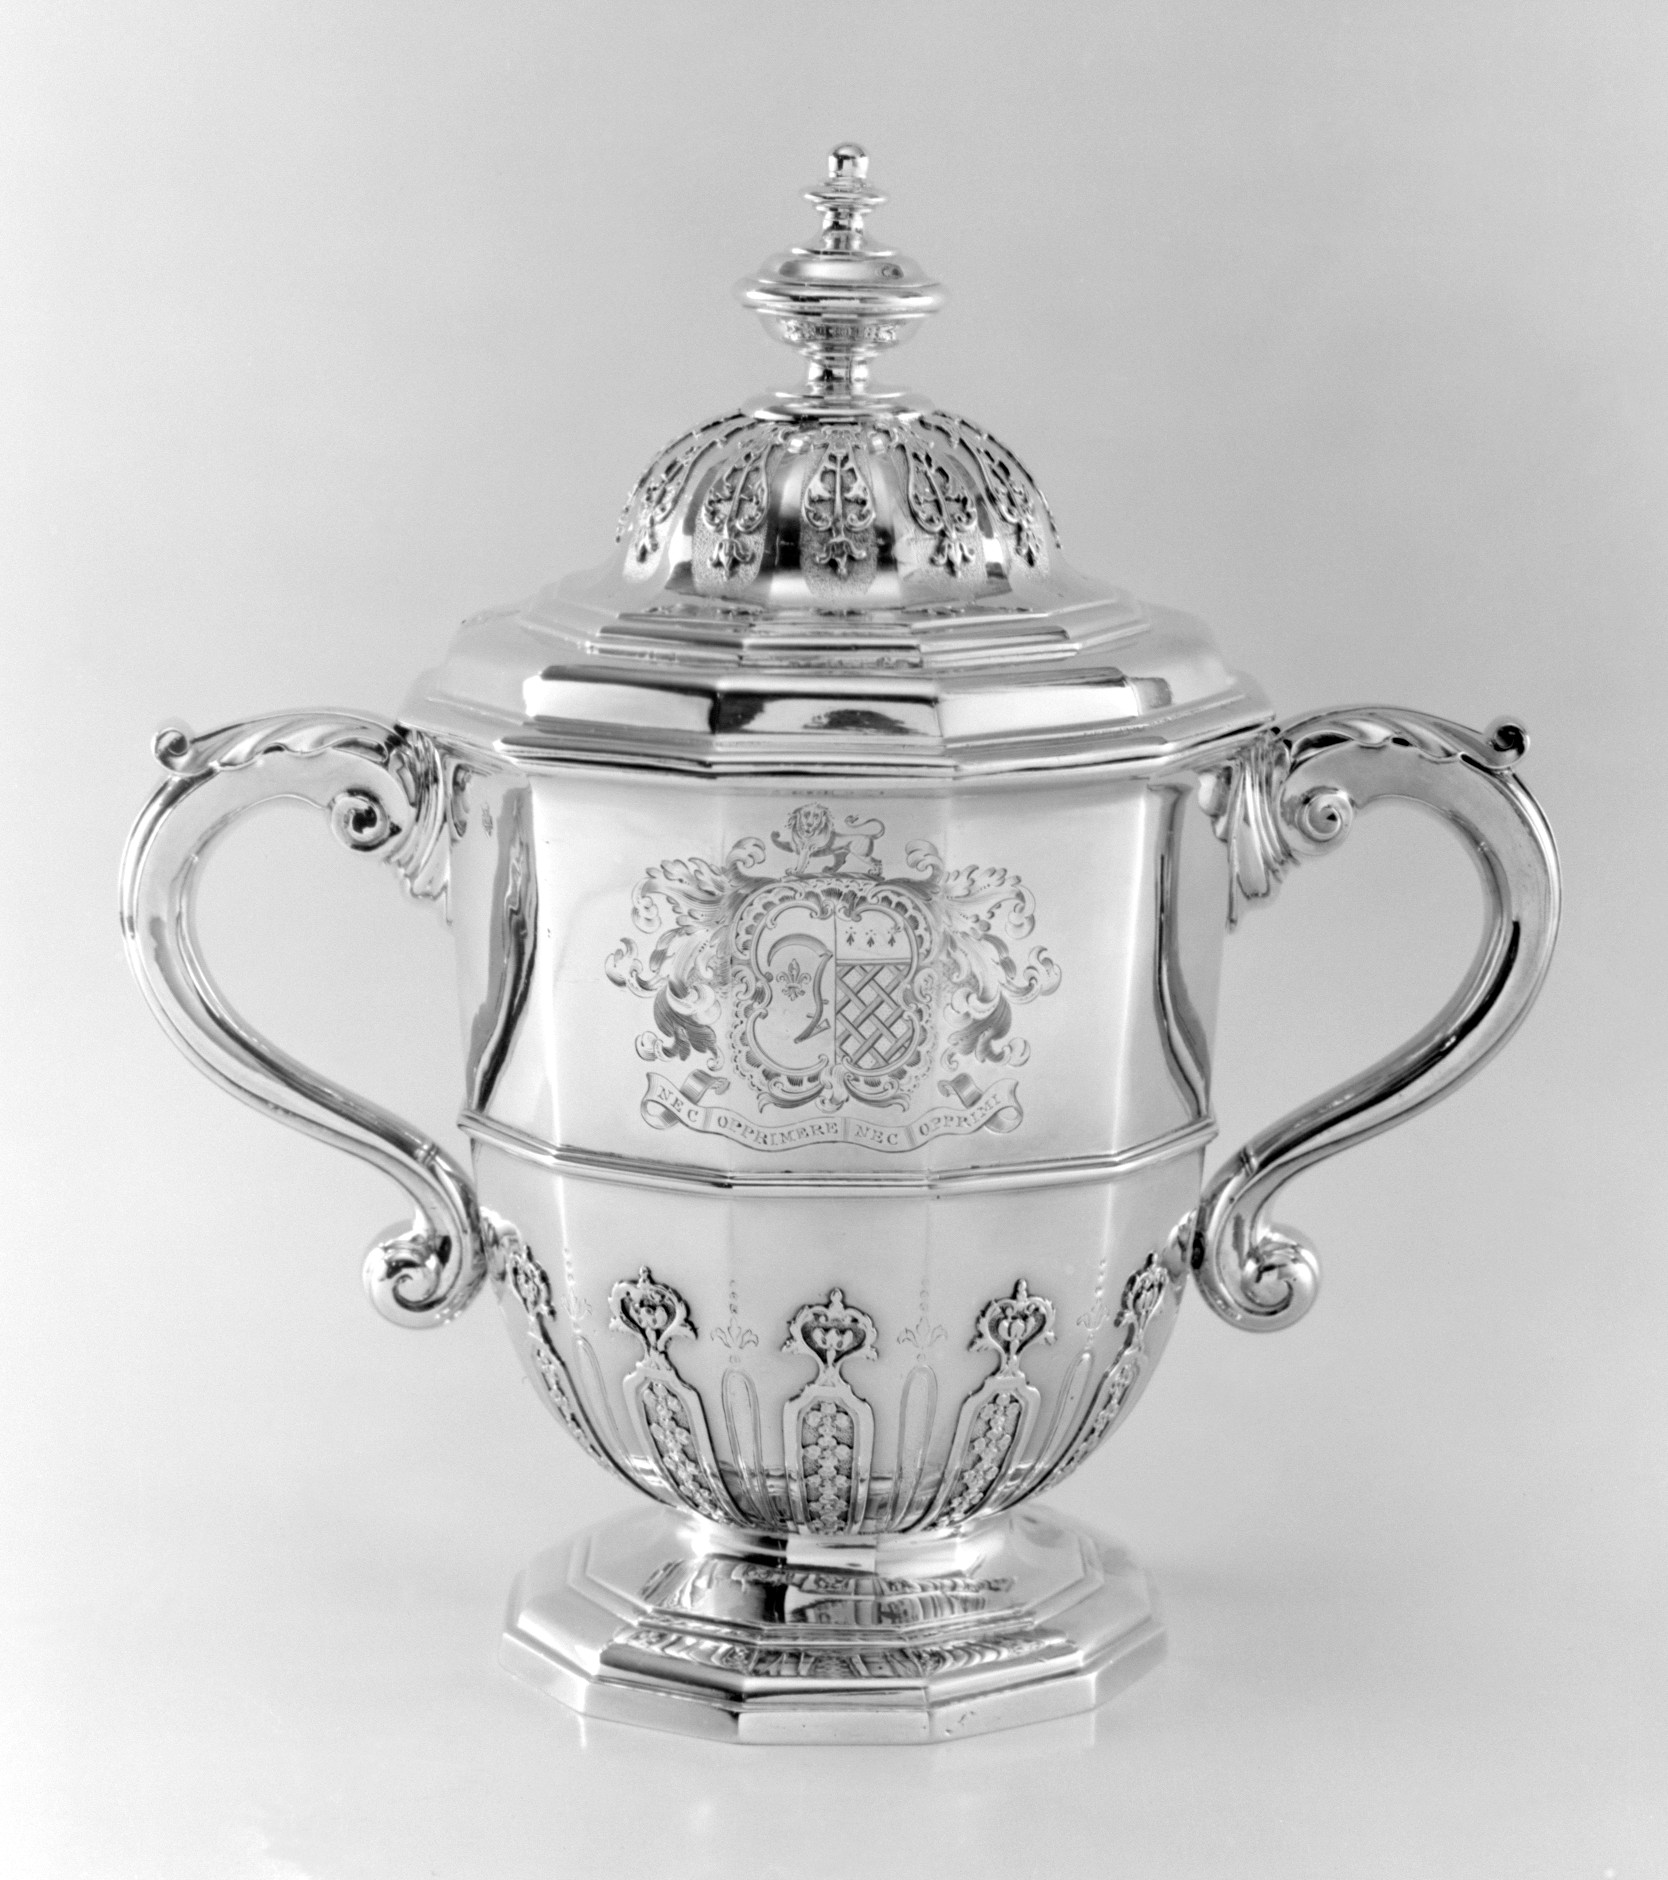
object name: cup with cover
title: Two-handled cup with cover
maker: paul de lamerie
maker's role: maker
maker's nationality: british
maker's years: 1688-1751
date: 1720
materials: silver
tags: coat of arms